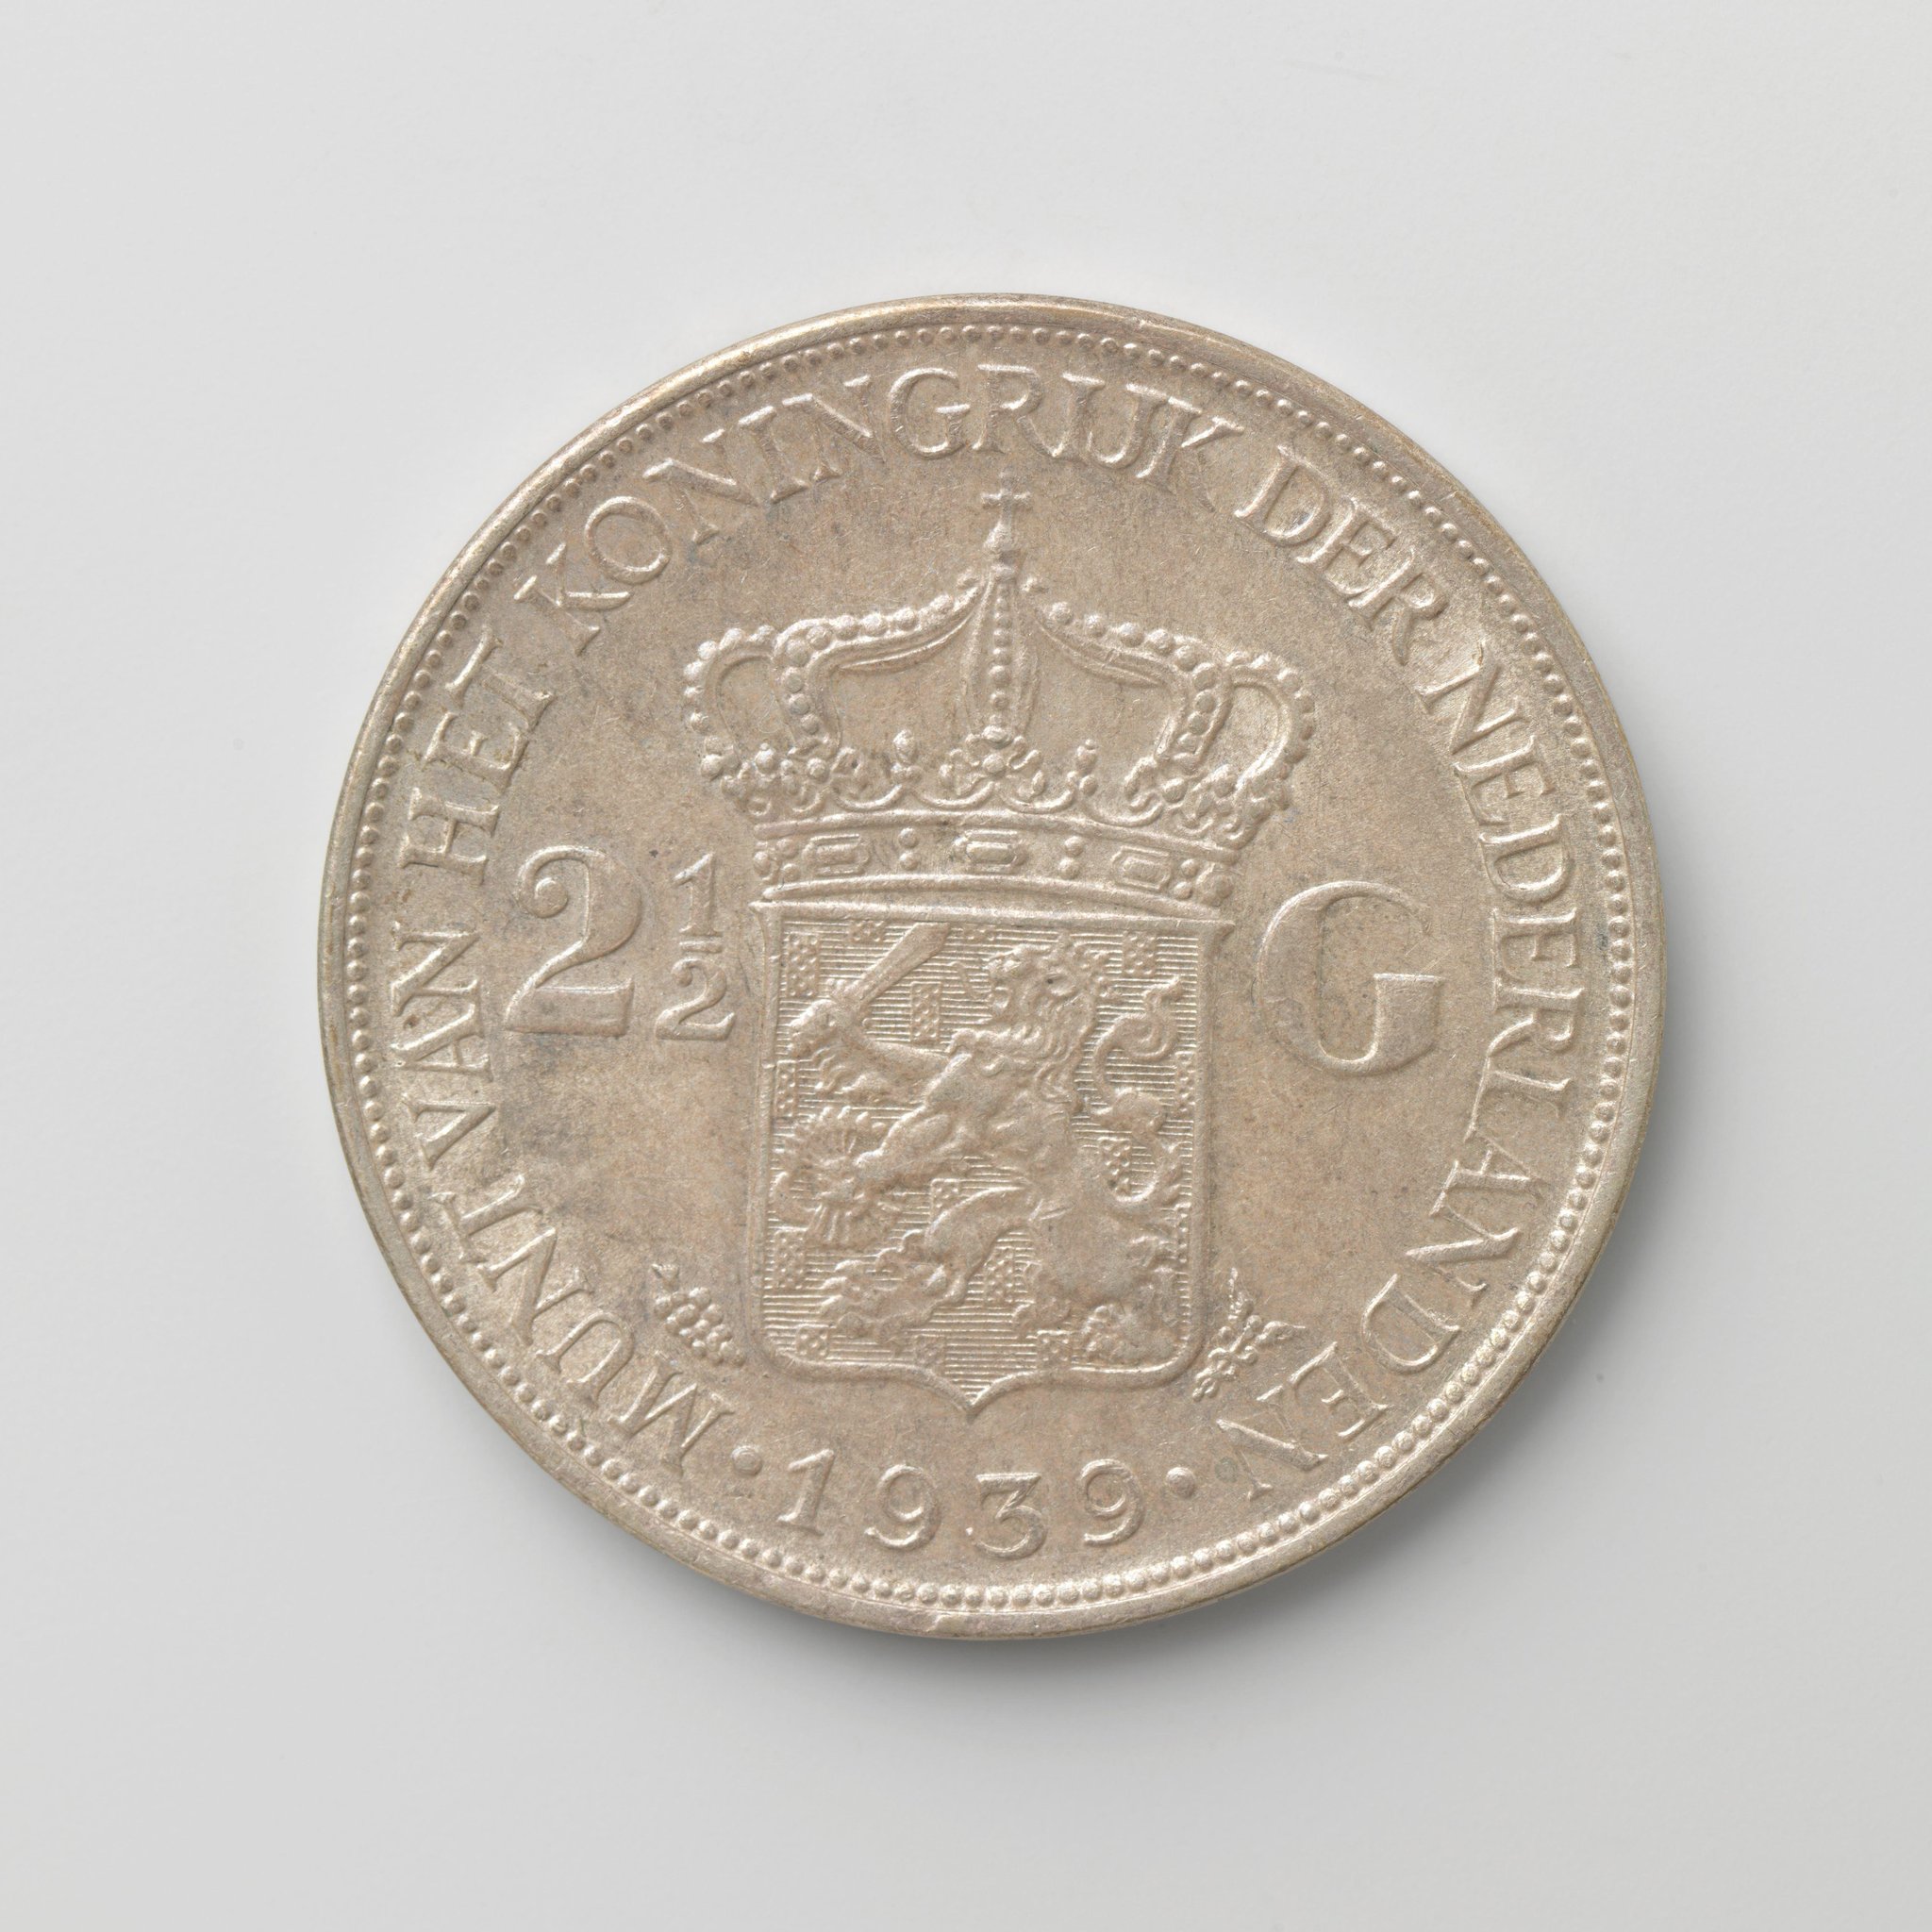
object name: coin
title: Nederlandse 2½ gulden,1939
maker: wilhelmina of the netherlands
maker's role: print maker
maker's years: 1880-1962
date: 1939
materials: silver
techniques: striking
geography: utrecht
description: Zilveren munt. Voorzijde: hoofd naar links. Keerzijde: tussen waarde-aanduiding 2½ G gekroond rijkswapenschild. Jaartal onderaan in omschrift. Randschrift.